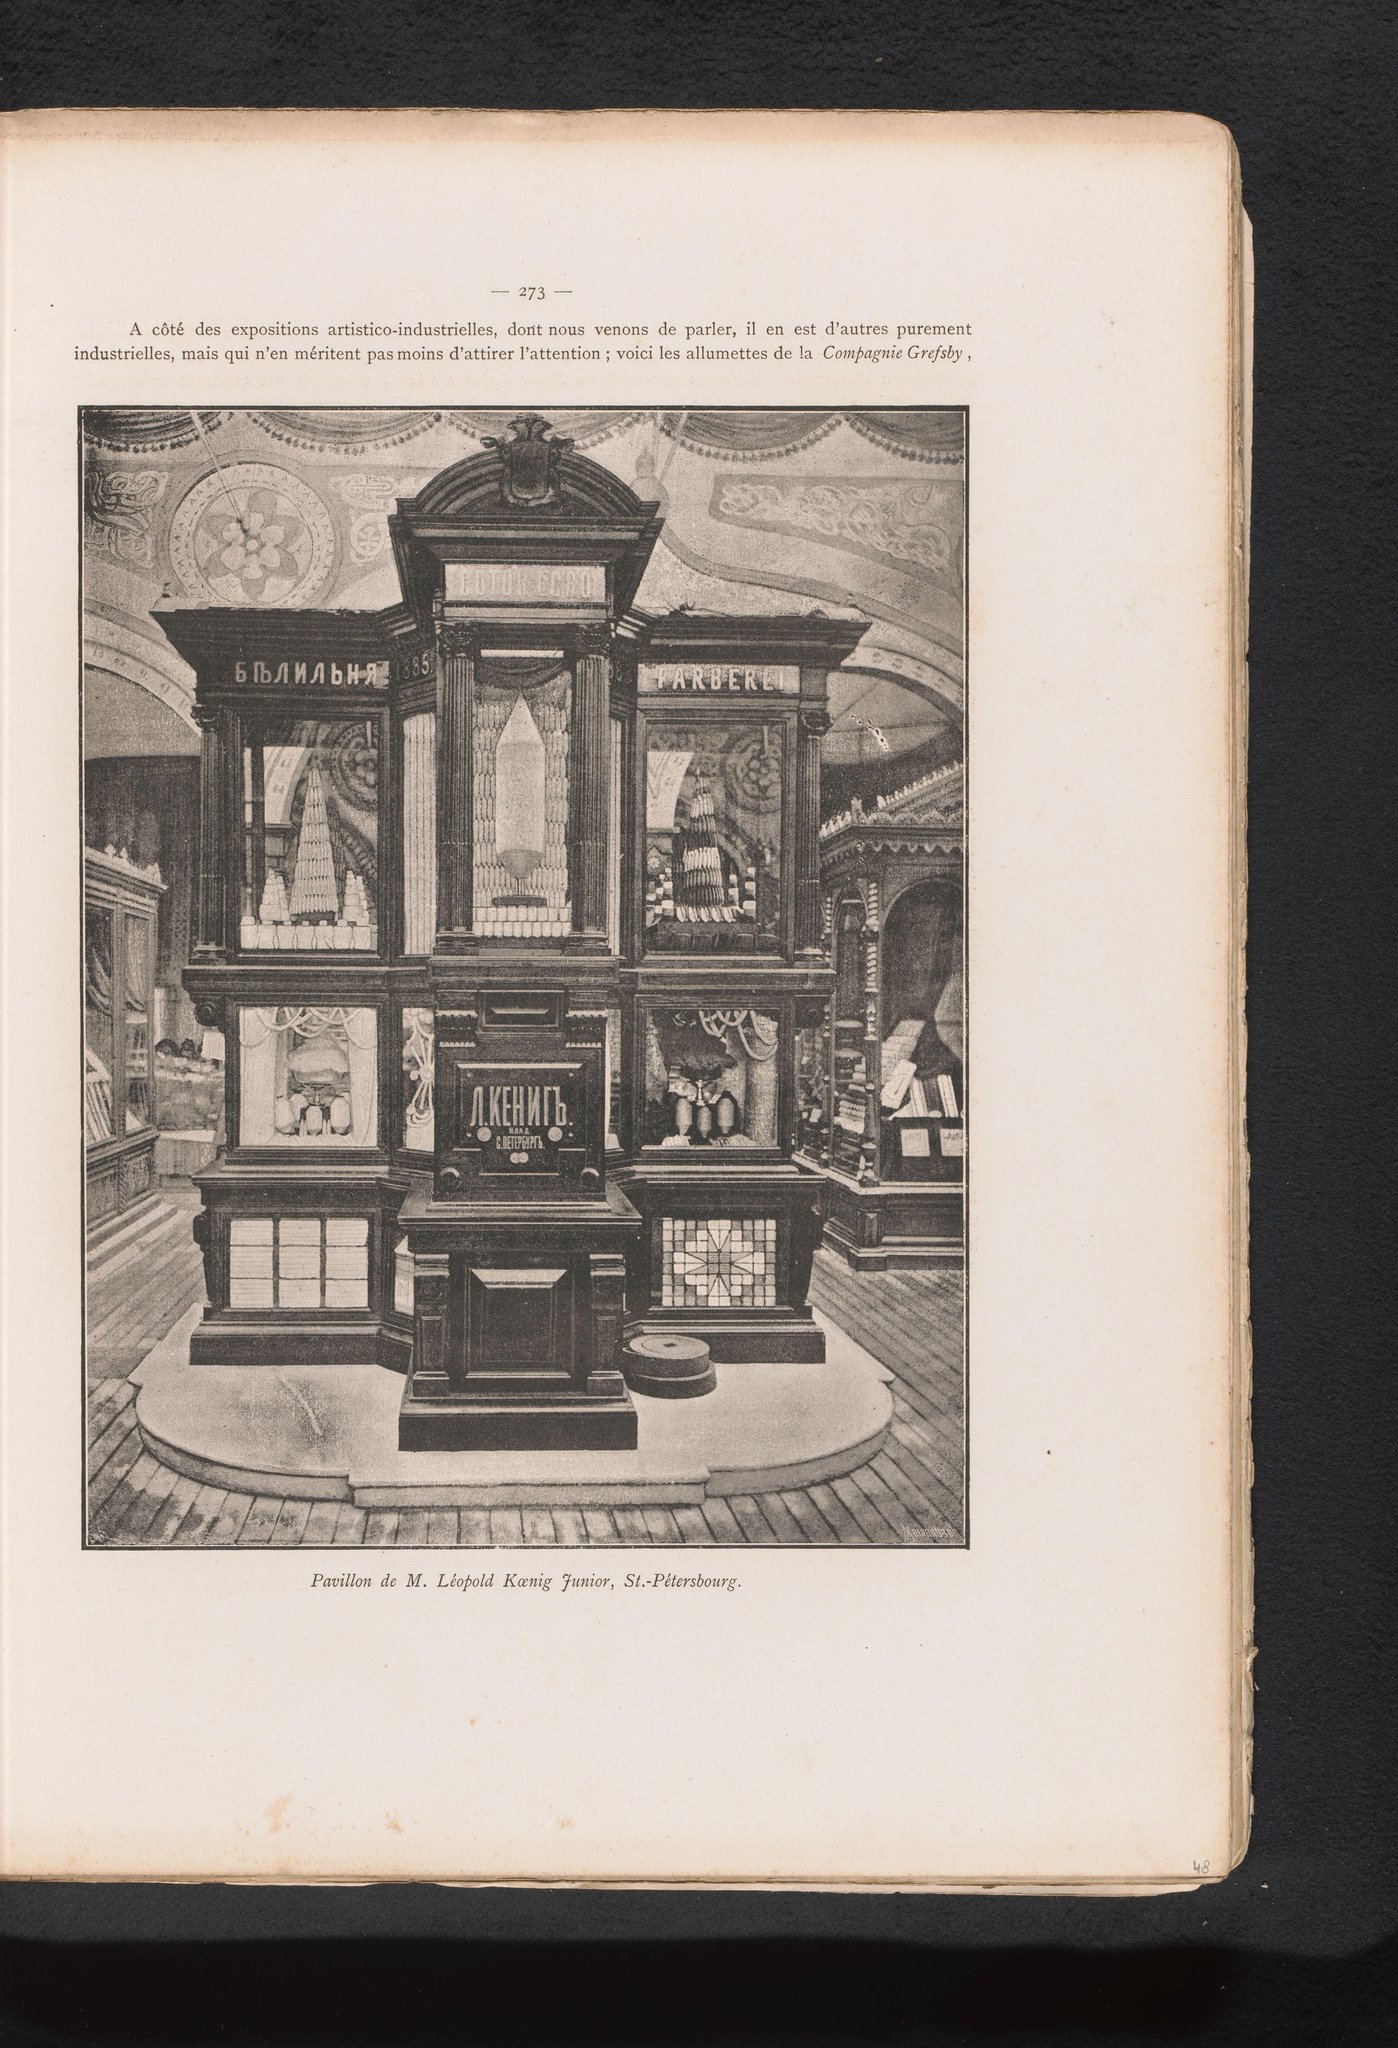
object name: photomechanical print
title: Gezicht op het paviljoen van Léopold Koenig Junior op de Wereldtentoonstelling van 1885 in Antwerpen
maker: Anonymous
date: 1880-1885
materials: paper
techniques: autotype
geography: antwerp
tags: world fair, world exhibition, antwerp